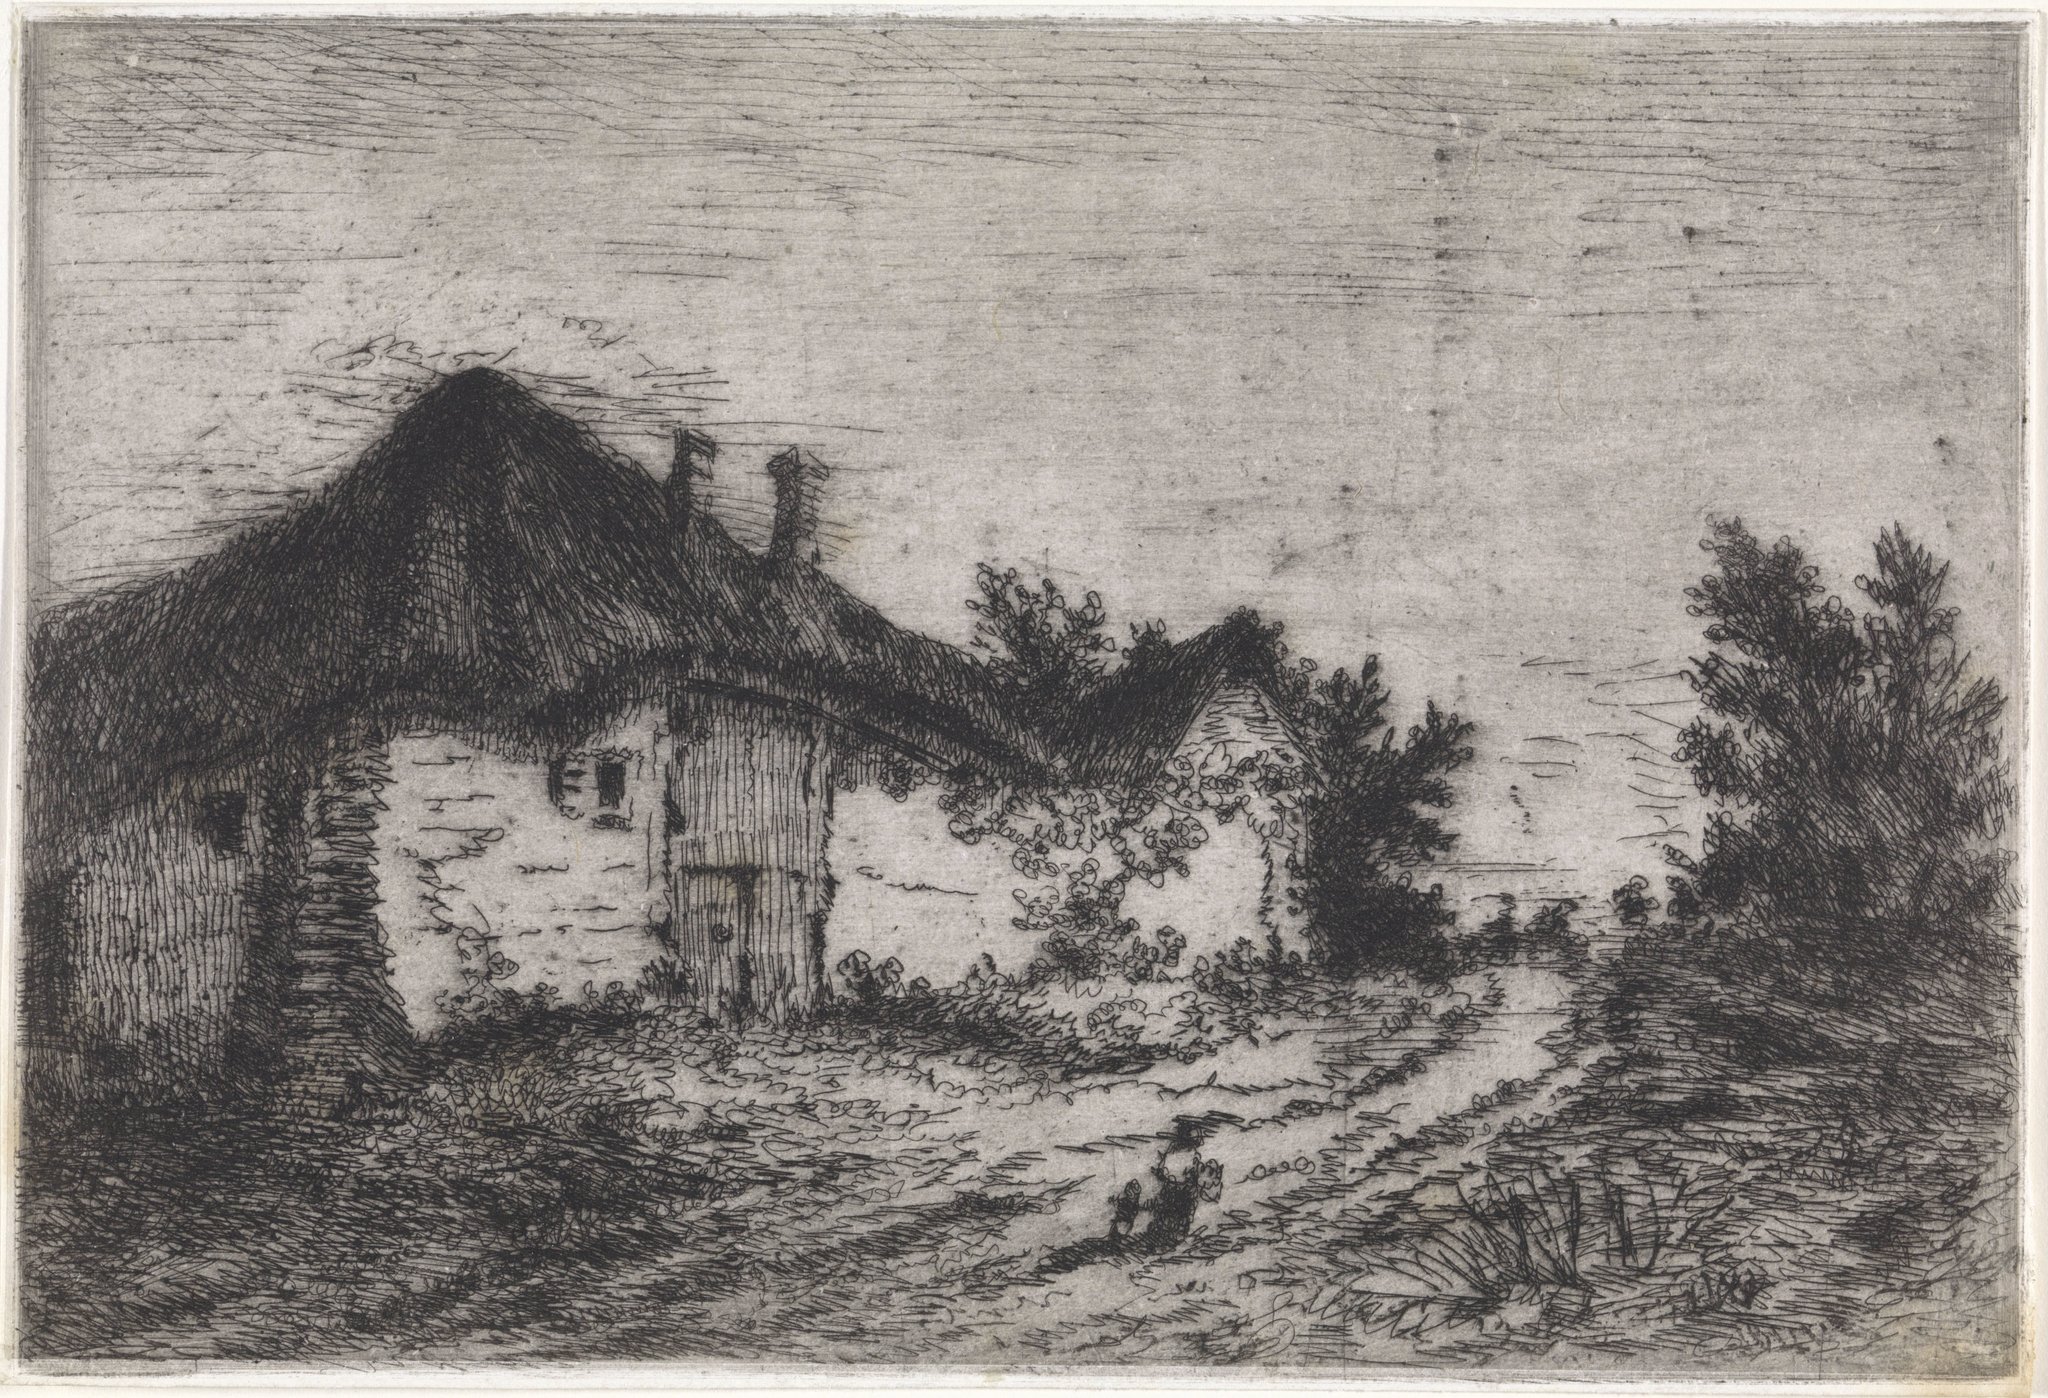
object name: print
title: Rietgedekte hut met twee schoorstenen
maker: arnoud schaepkens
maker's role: print maker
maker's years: 1816-1904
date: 1855-1904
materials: paper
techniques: drypoint, etching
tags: cottage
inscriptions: collector's mark: Lugt 2228